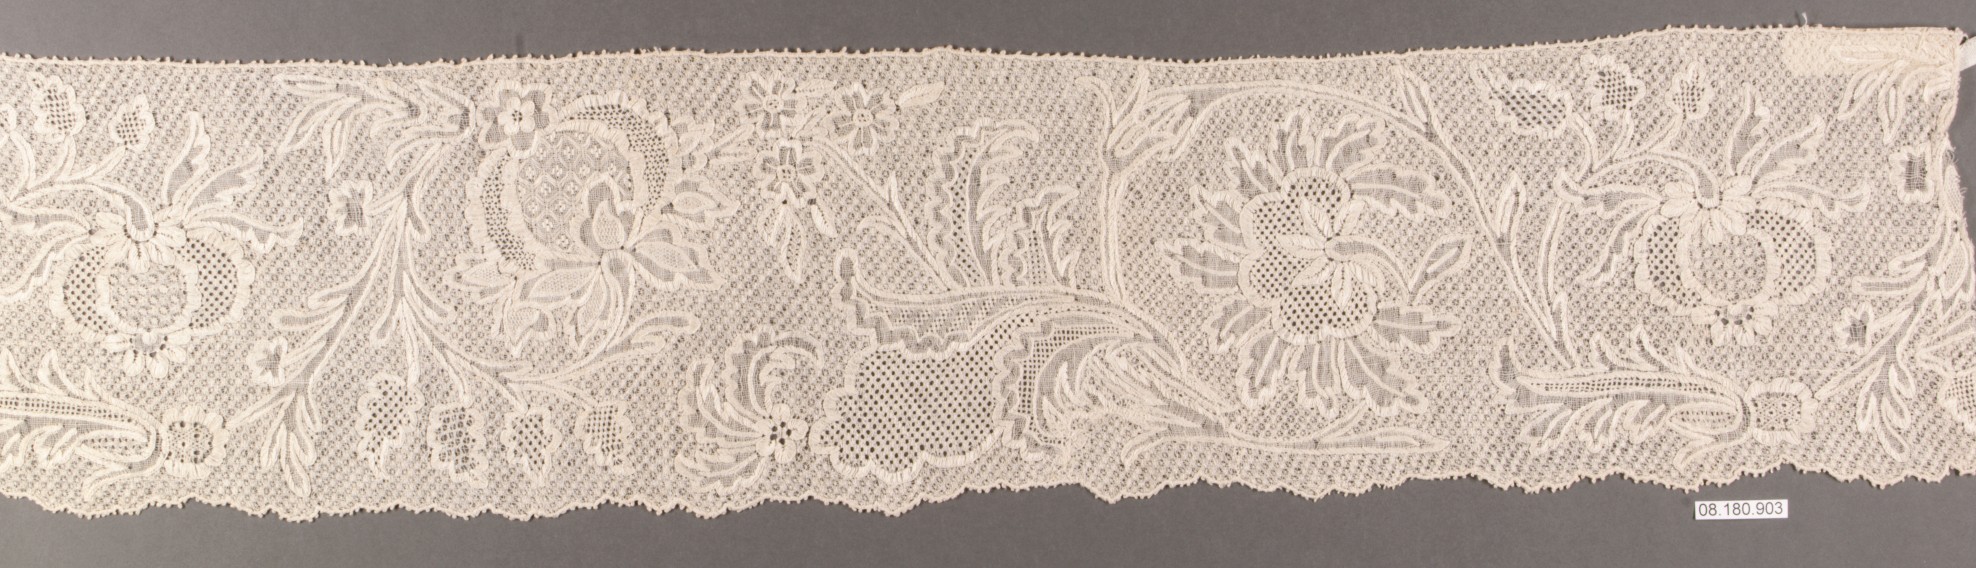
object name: border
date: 1701-1800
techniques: embroidery